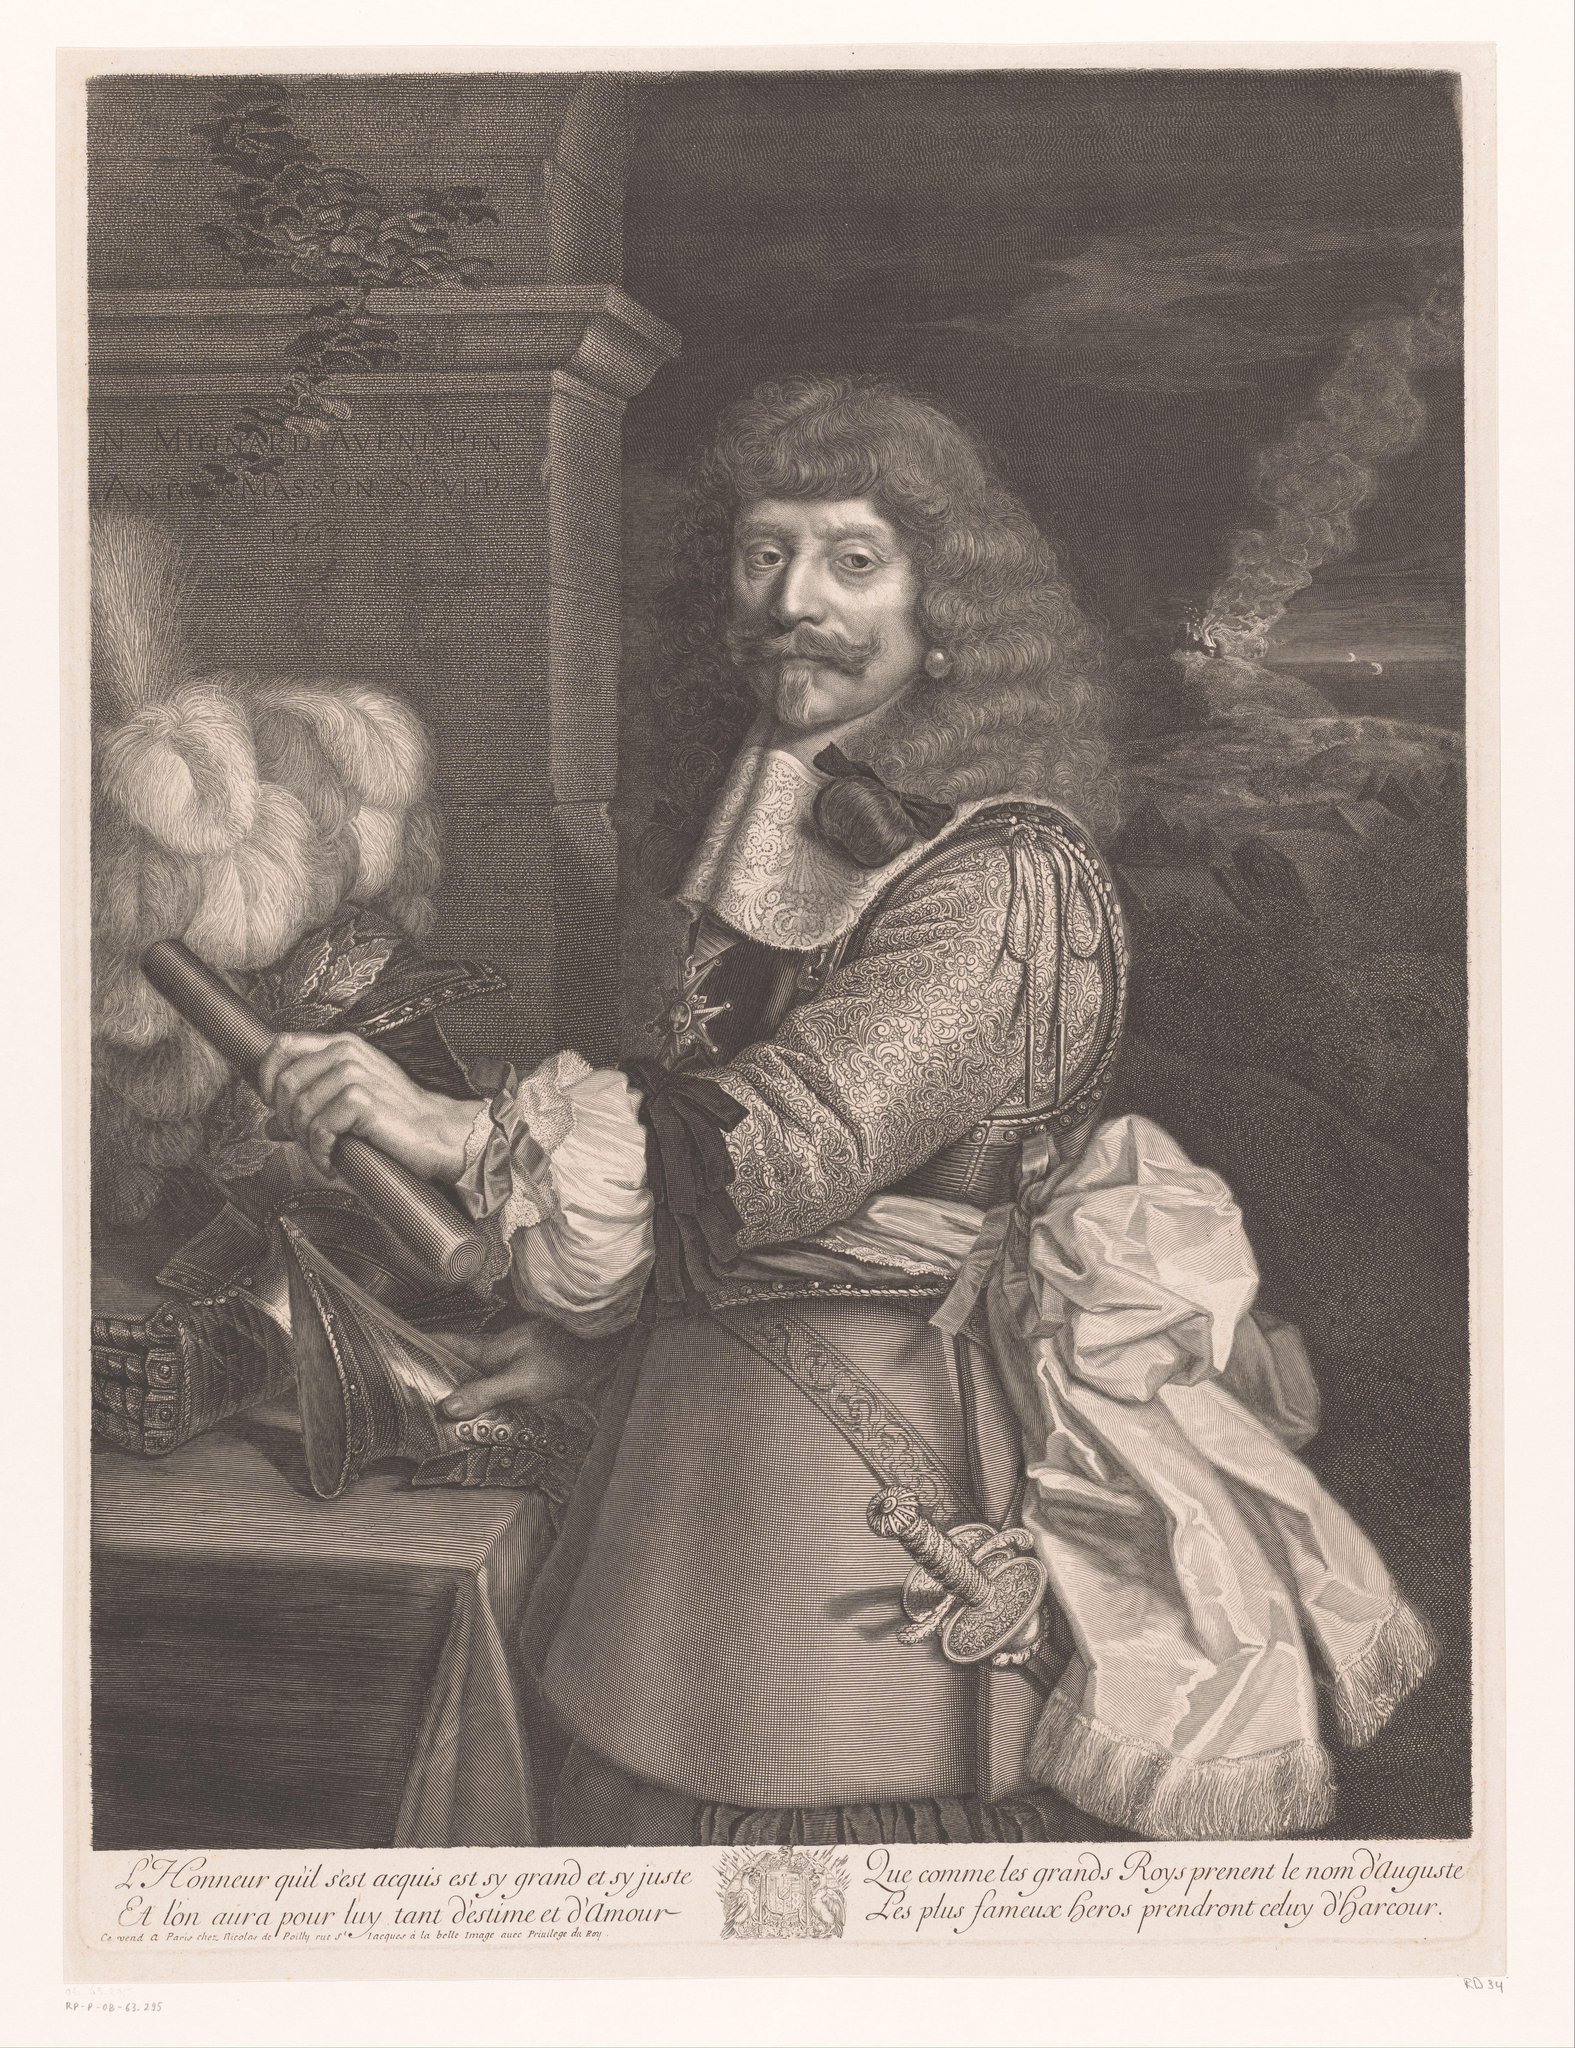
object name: print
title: Portret van Hendrik van Harcourt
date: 1667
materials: paper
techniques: engraving, etching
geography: paris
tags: hendrik van lotharingen (graaf van harcourt), historical persons, armorial bearing, heraldry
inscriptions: collector's mark: Lugt 2228